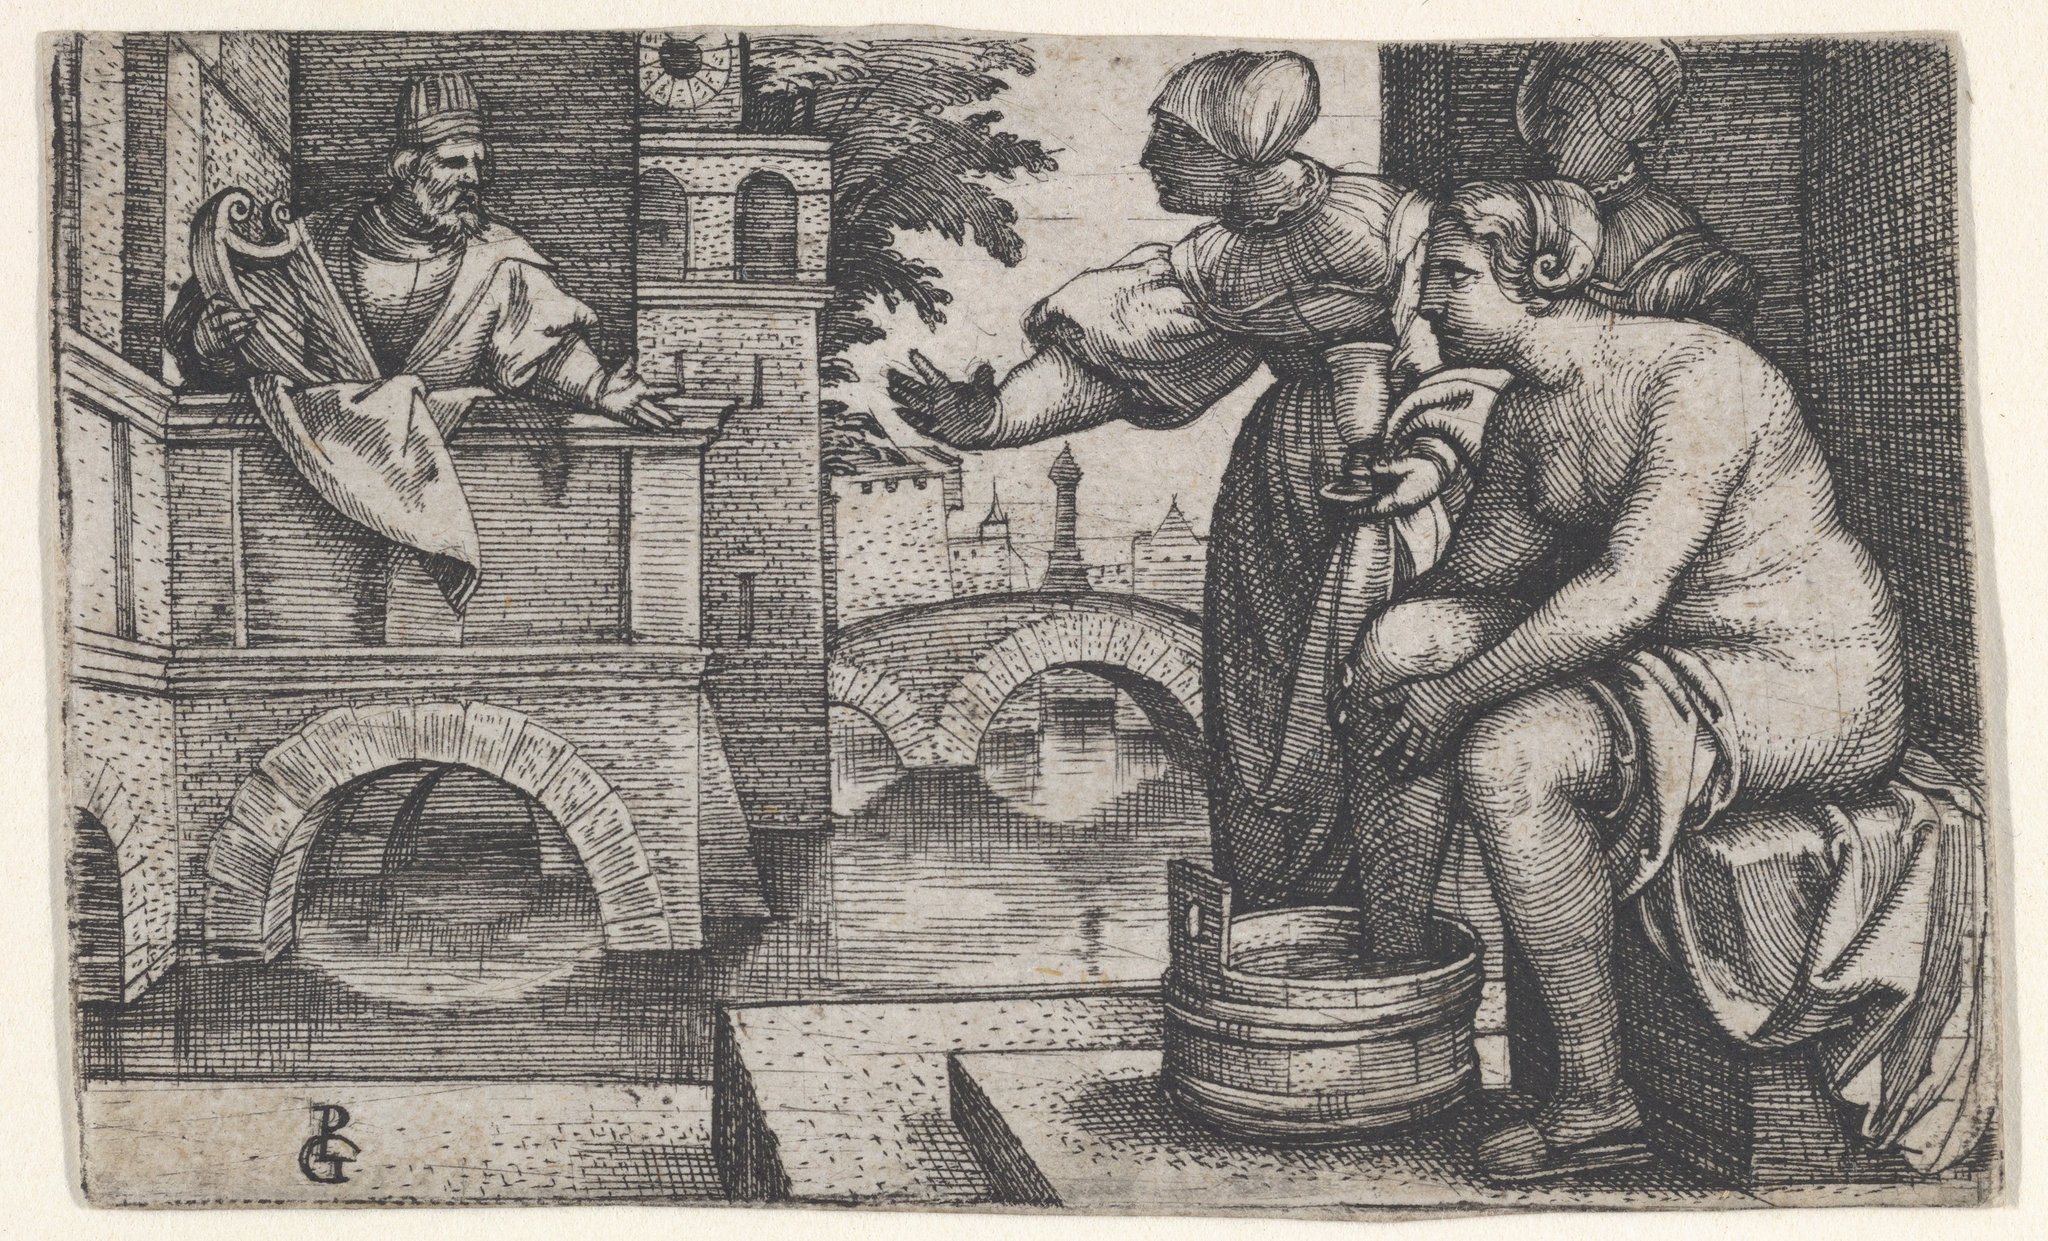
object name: print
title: David and Bathsheba, from "Scenes from the Old Testament"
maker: georg pencz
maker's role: artist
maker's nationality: german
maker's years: 1500-1550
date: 1526-1536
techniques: engraving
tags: women,female nudes,bathsheba,david